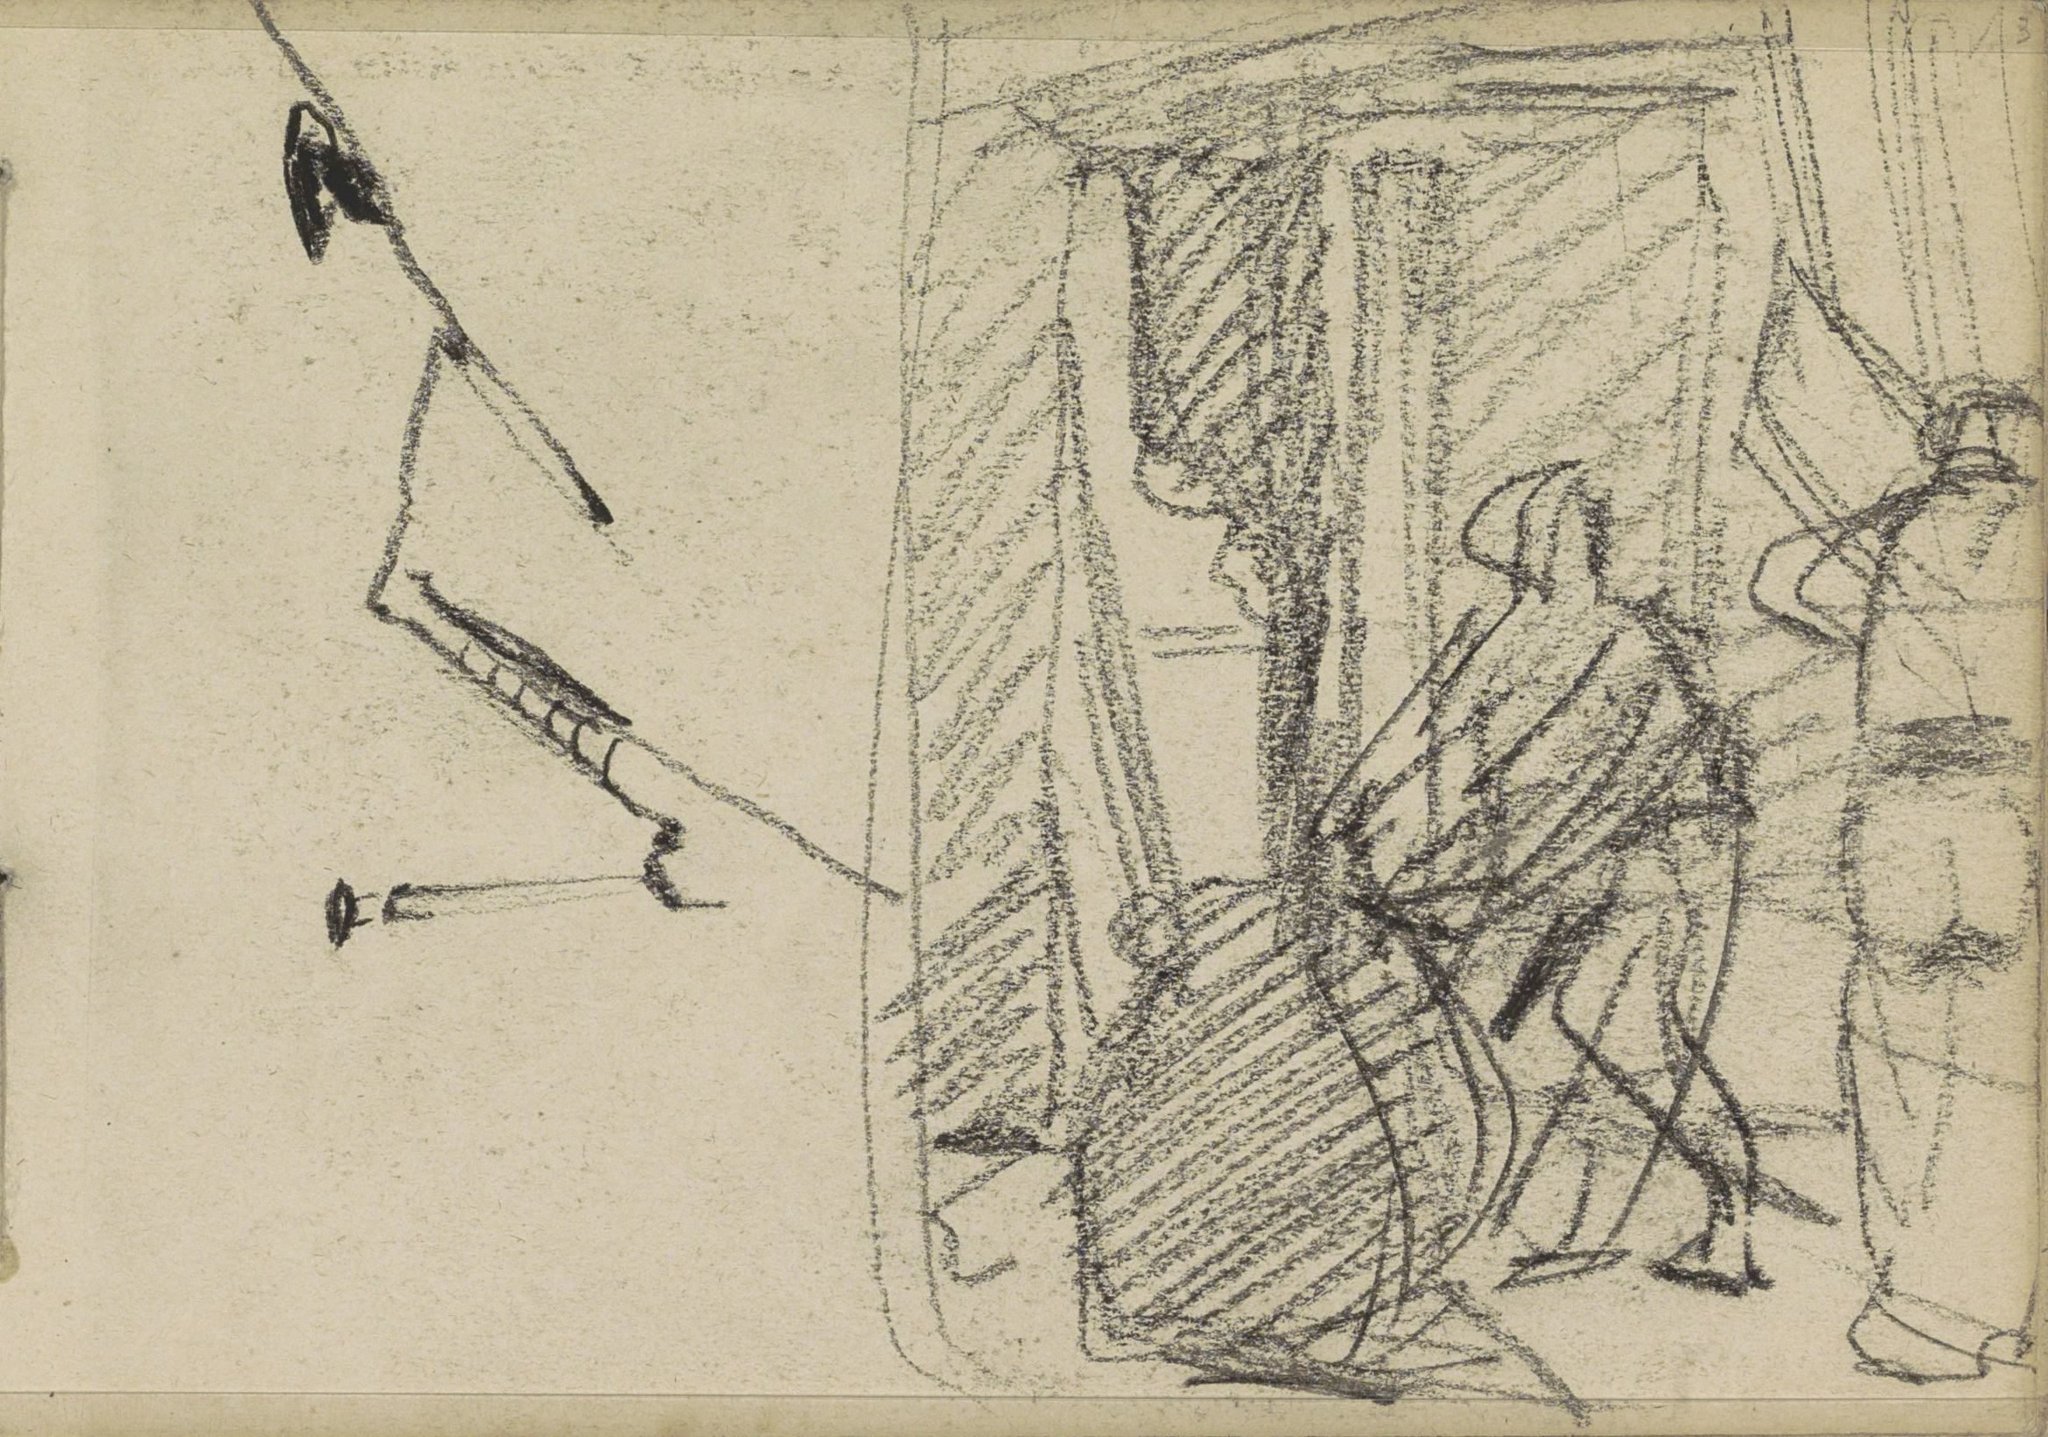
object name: sketchbook leaf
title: Molenaar met open deur en een architectuurstudie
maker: willem witsen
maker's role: draughtsman, painter, print maker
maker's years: 1860-1923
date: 1906-1907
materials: chalk, paper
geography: wijk bij duurstede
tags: windmill (+ men (labourers)), architecture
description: Voorstudie voor de ets 'Molenaar met open deur', ca. 1908.